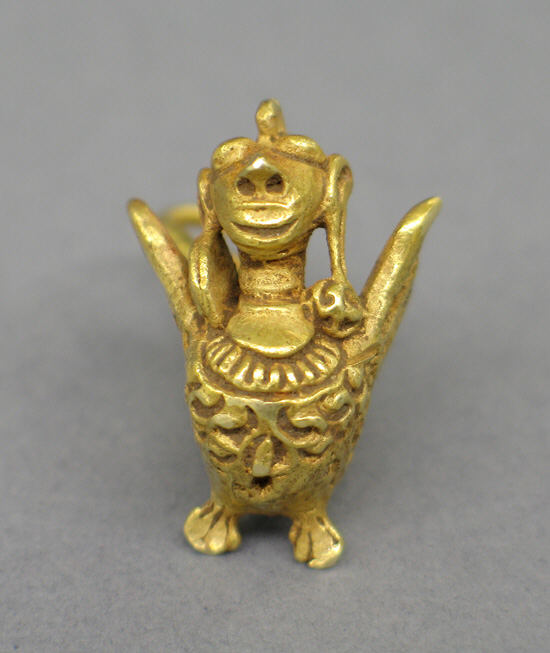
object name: clothing fastener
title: Clothing Fastener (Button) with Kinnara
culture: indonesian, javanese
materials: gold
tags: mythical creatures